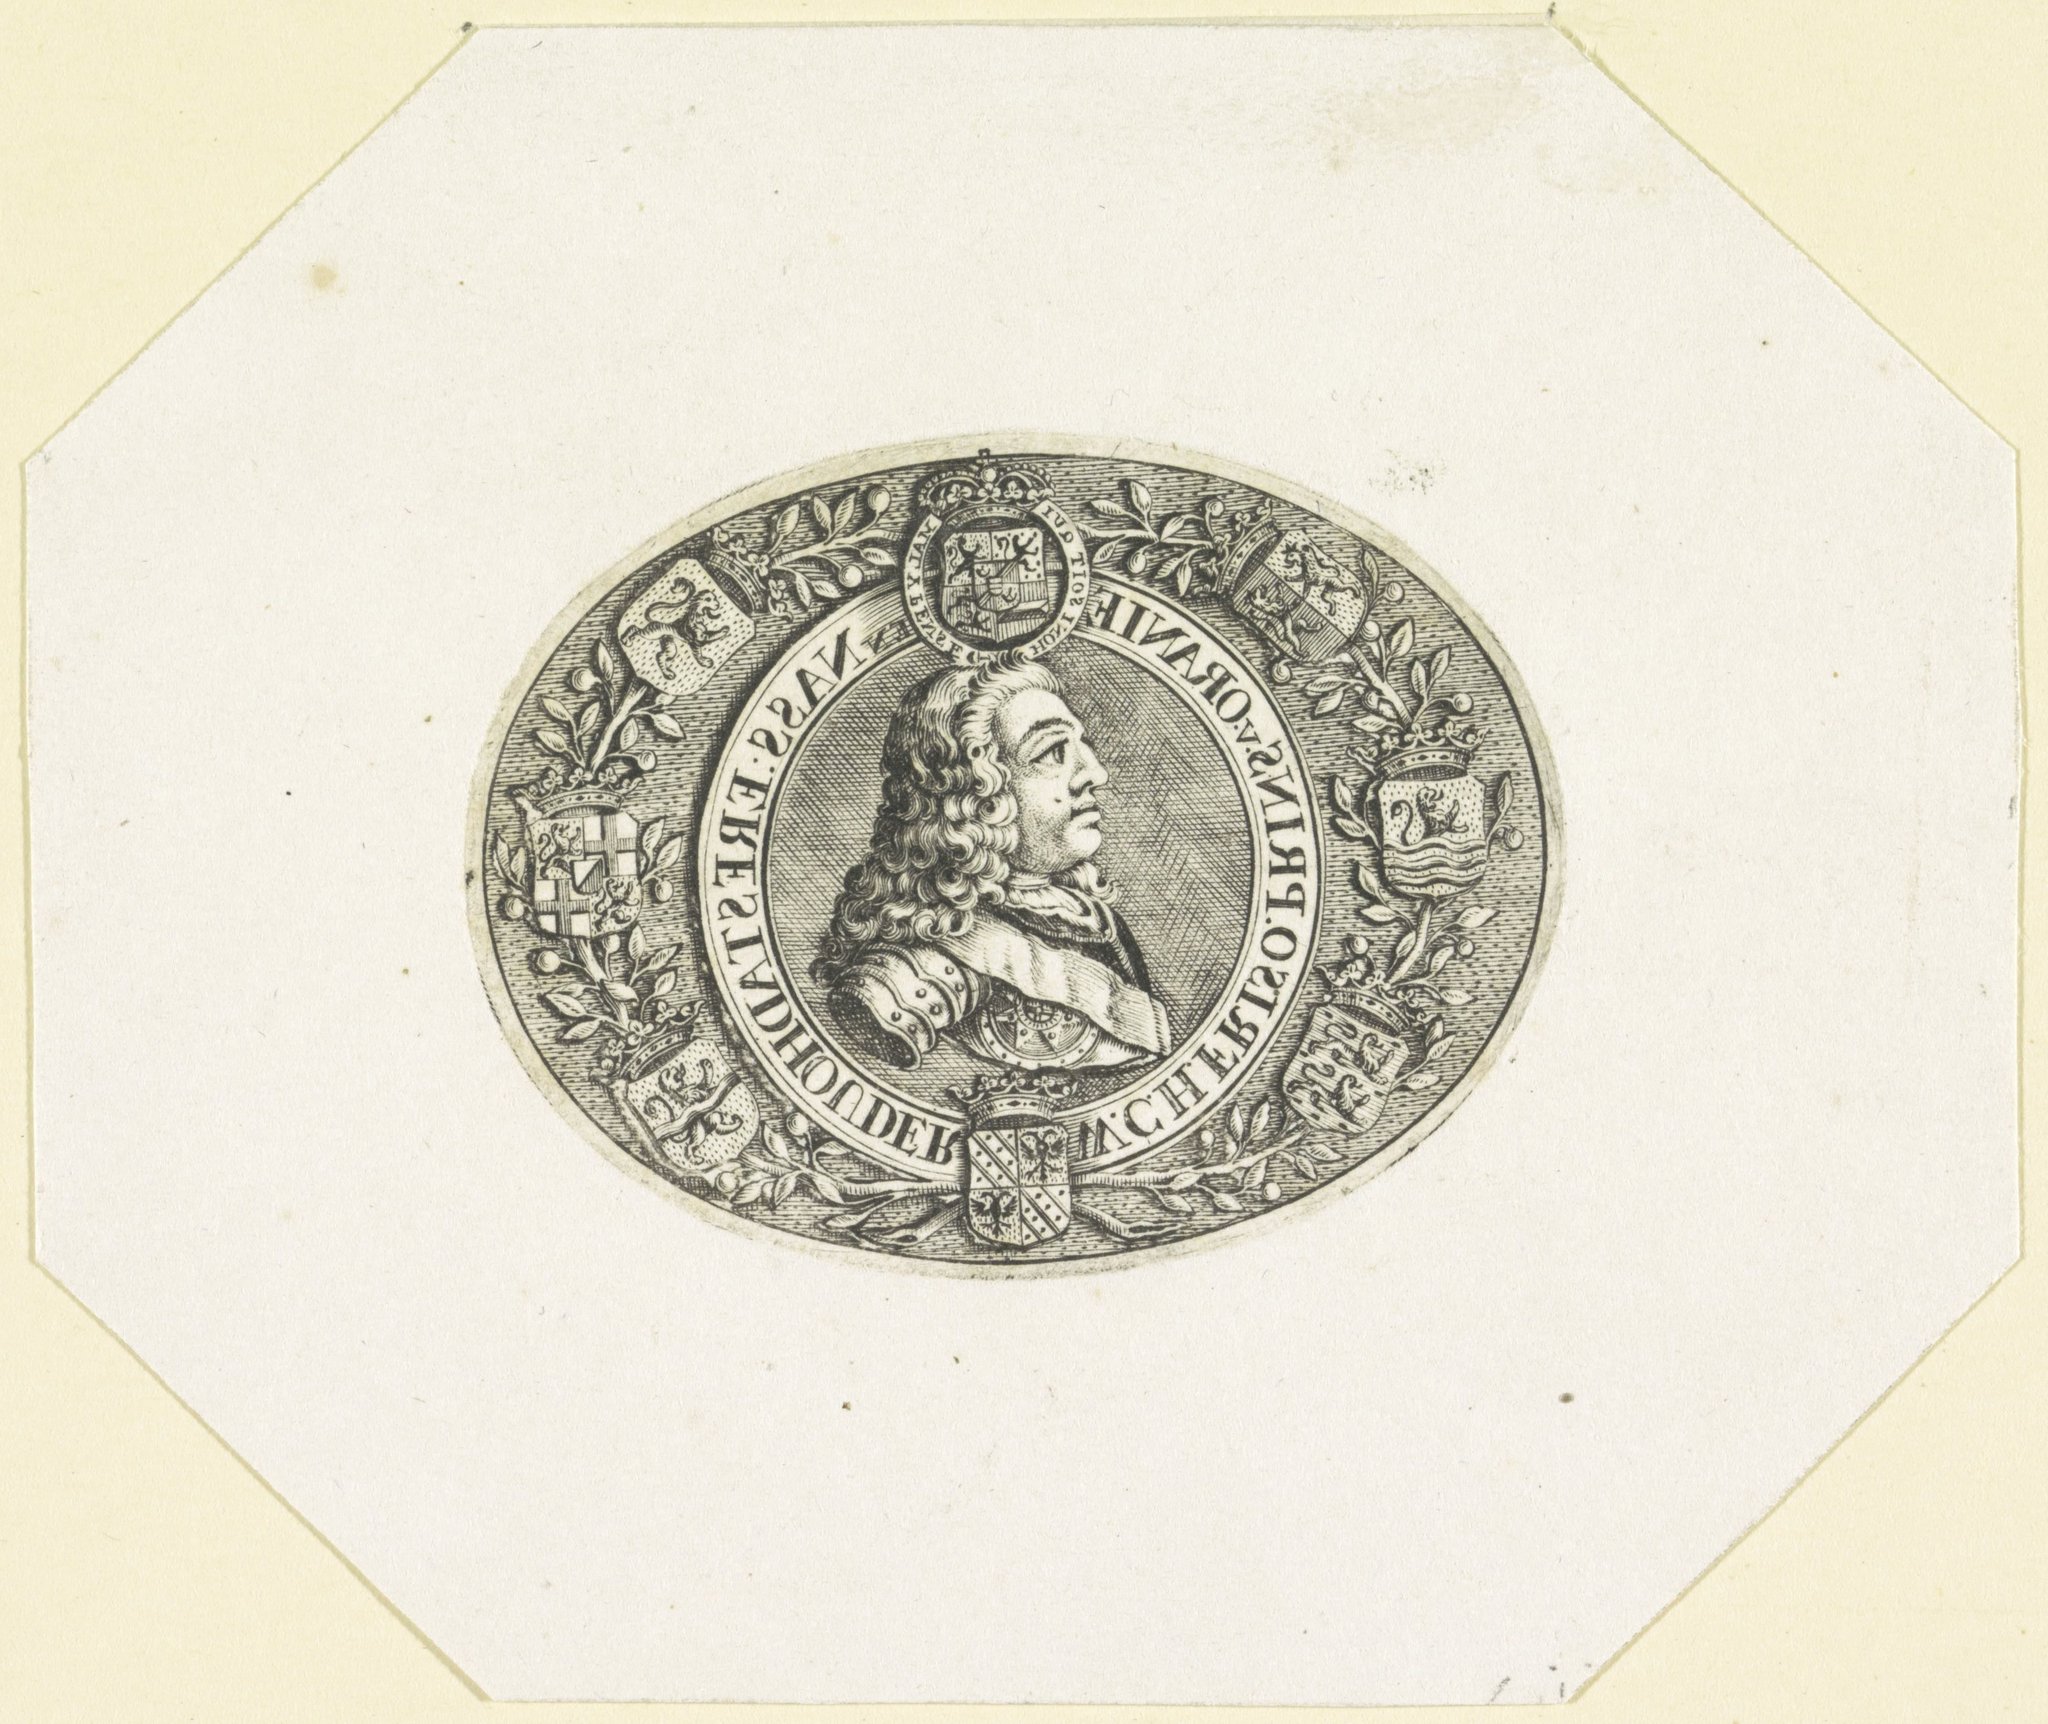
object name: print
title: Portret van Willem IV, prins van Oranje-Nassau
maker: Anonymous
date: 1747-1799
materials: paper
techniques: engraving, etching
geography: low countries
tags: the hague, willem iv (prins van oranje-nassau), knighthood order (garter) - insignia of a knighthood order, e.g.: badge, chain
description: Portret van Willem IV in een cirkel met randschrift. Daar omheen een ovale omlijsting met oranjetakken, zijn wapen met een kroon, gedecoreerd met de Kousenband en het devies van de Orde van de Kousenband, en de wapens van de Zeven Provinciën. In spiegelbeeld.